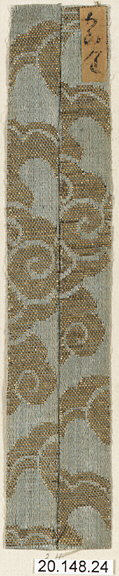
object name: piece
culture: japanese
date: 1301-1400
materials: silk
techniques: compound weave